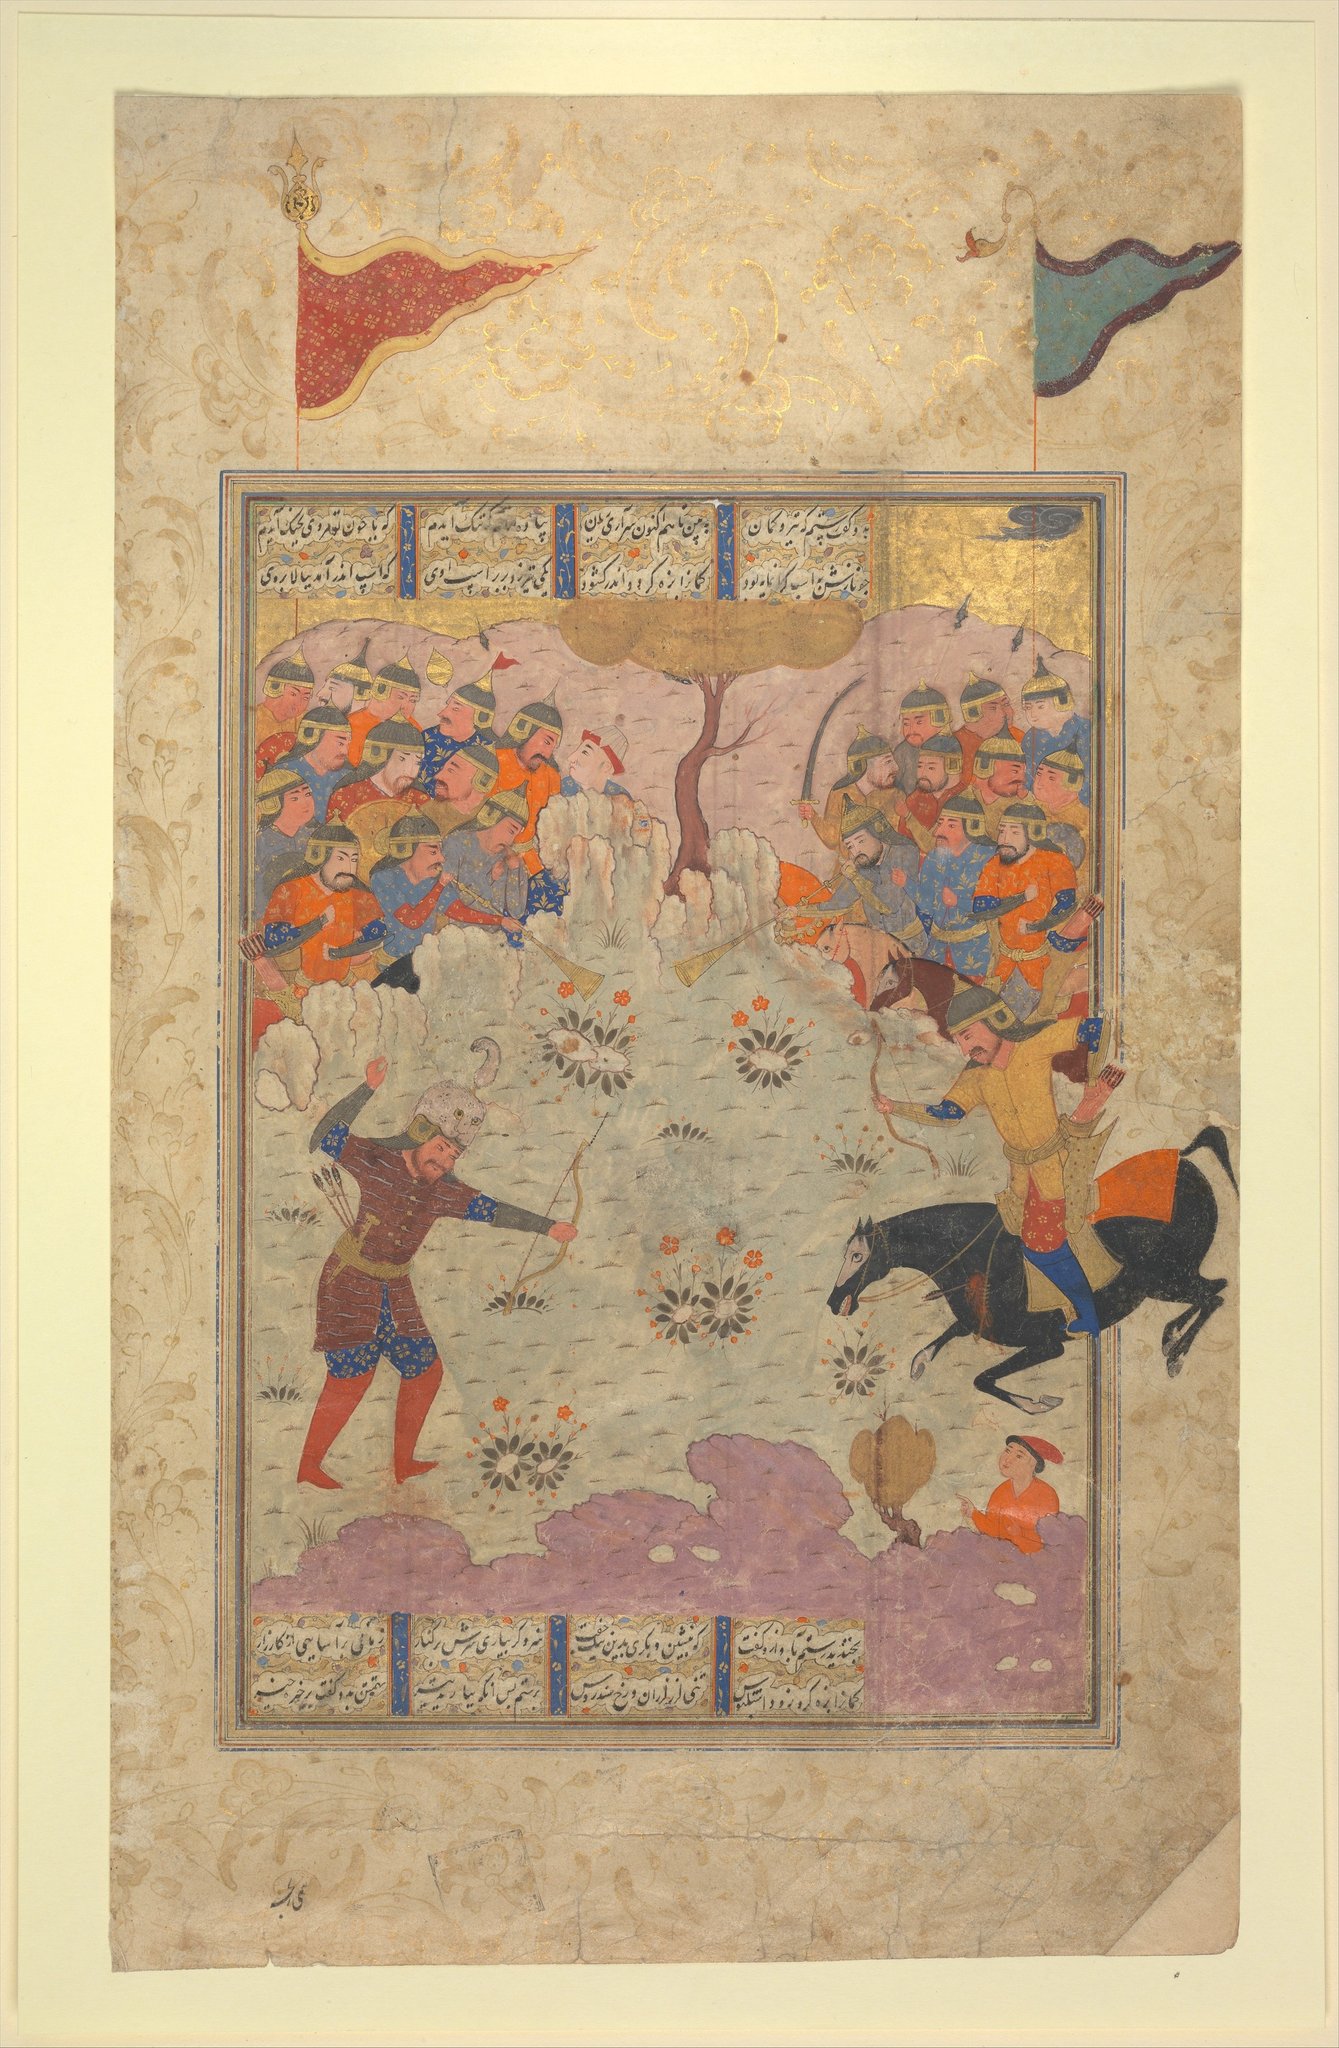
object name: folio from an illustrated manuscript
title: "Rustam Fighting Ashkabus", Folio from a Shahnama (Book of Kings)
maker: abu'l qasim firdausi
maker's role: artist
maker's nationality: iranian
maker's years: 935-1020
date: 1560-1580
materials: gold, paper, silver, watercolor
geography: iran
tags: bow and arrow,horses,flags